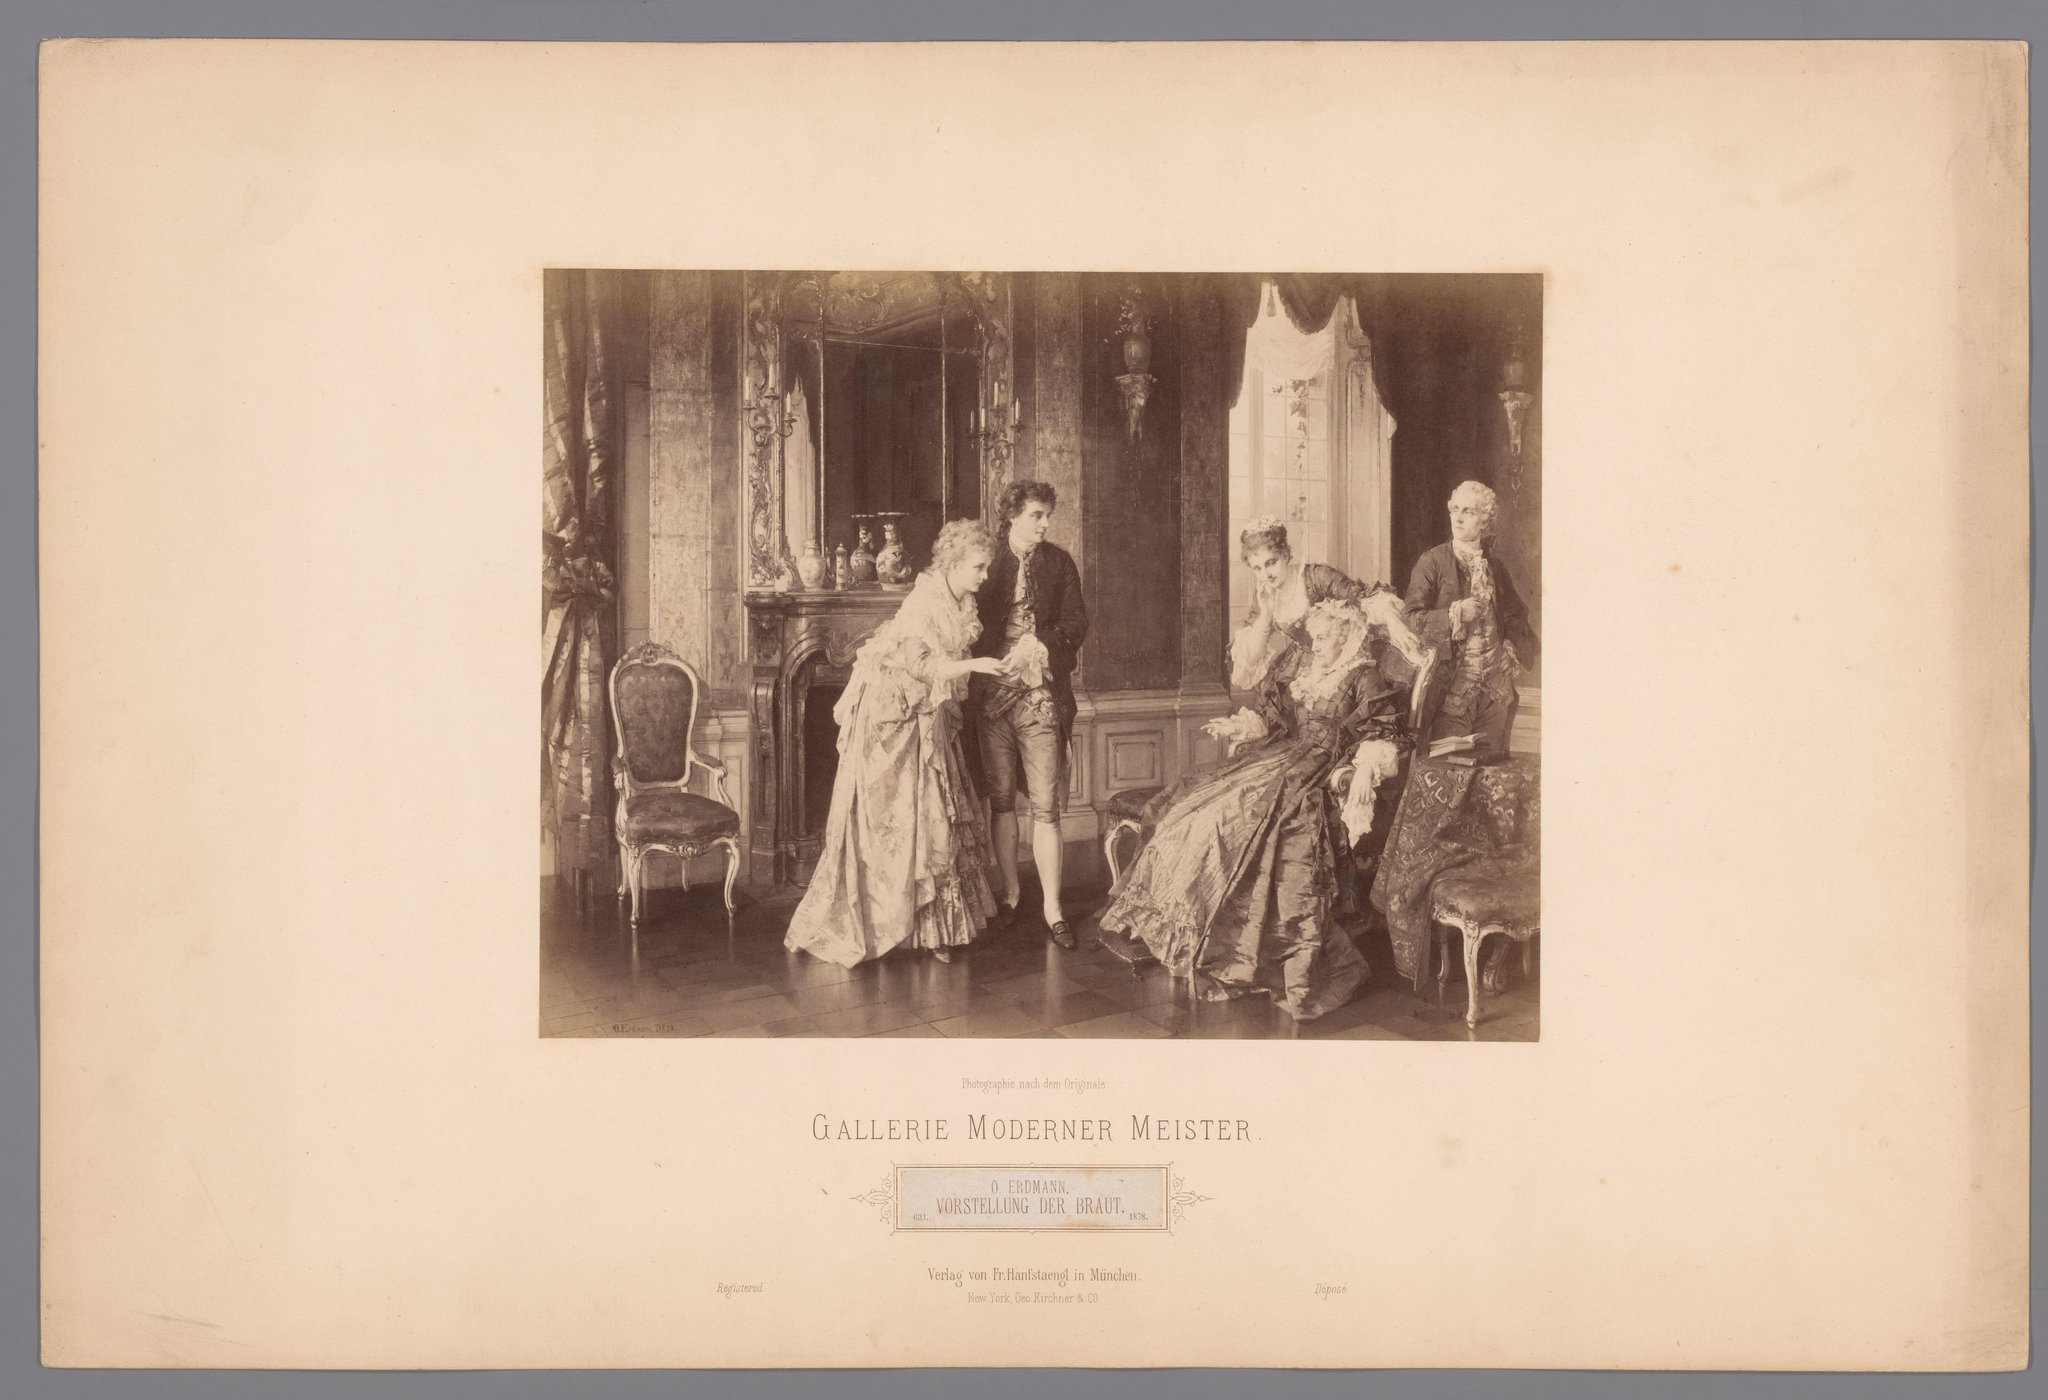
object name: photograph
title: Reproductie van schilderij "Vorstellung der Braut" van Otto Erdmann (1834-1905)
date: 1878-1900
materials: cardboard, paper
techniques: albumen print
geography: munich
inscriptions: caption: ‘Photographie nach dem Originale.//GALLERIE MODERNER MEISTER//O.ERDMANN. VORSTELLUNG DER BRAUT 631//1878//Verlag von Fr. Hanfstaengl in München//New York, Geo. Kirchner & Co.//Registered//Déposé’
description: Genretafereel met vijf mensen in een interieur.